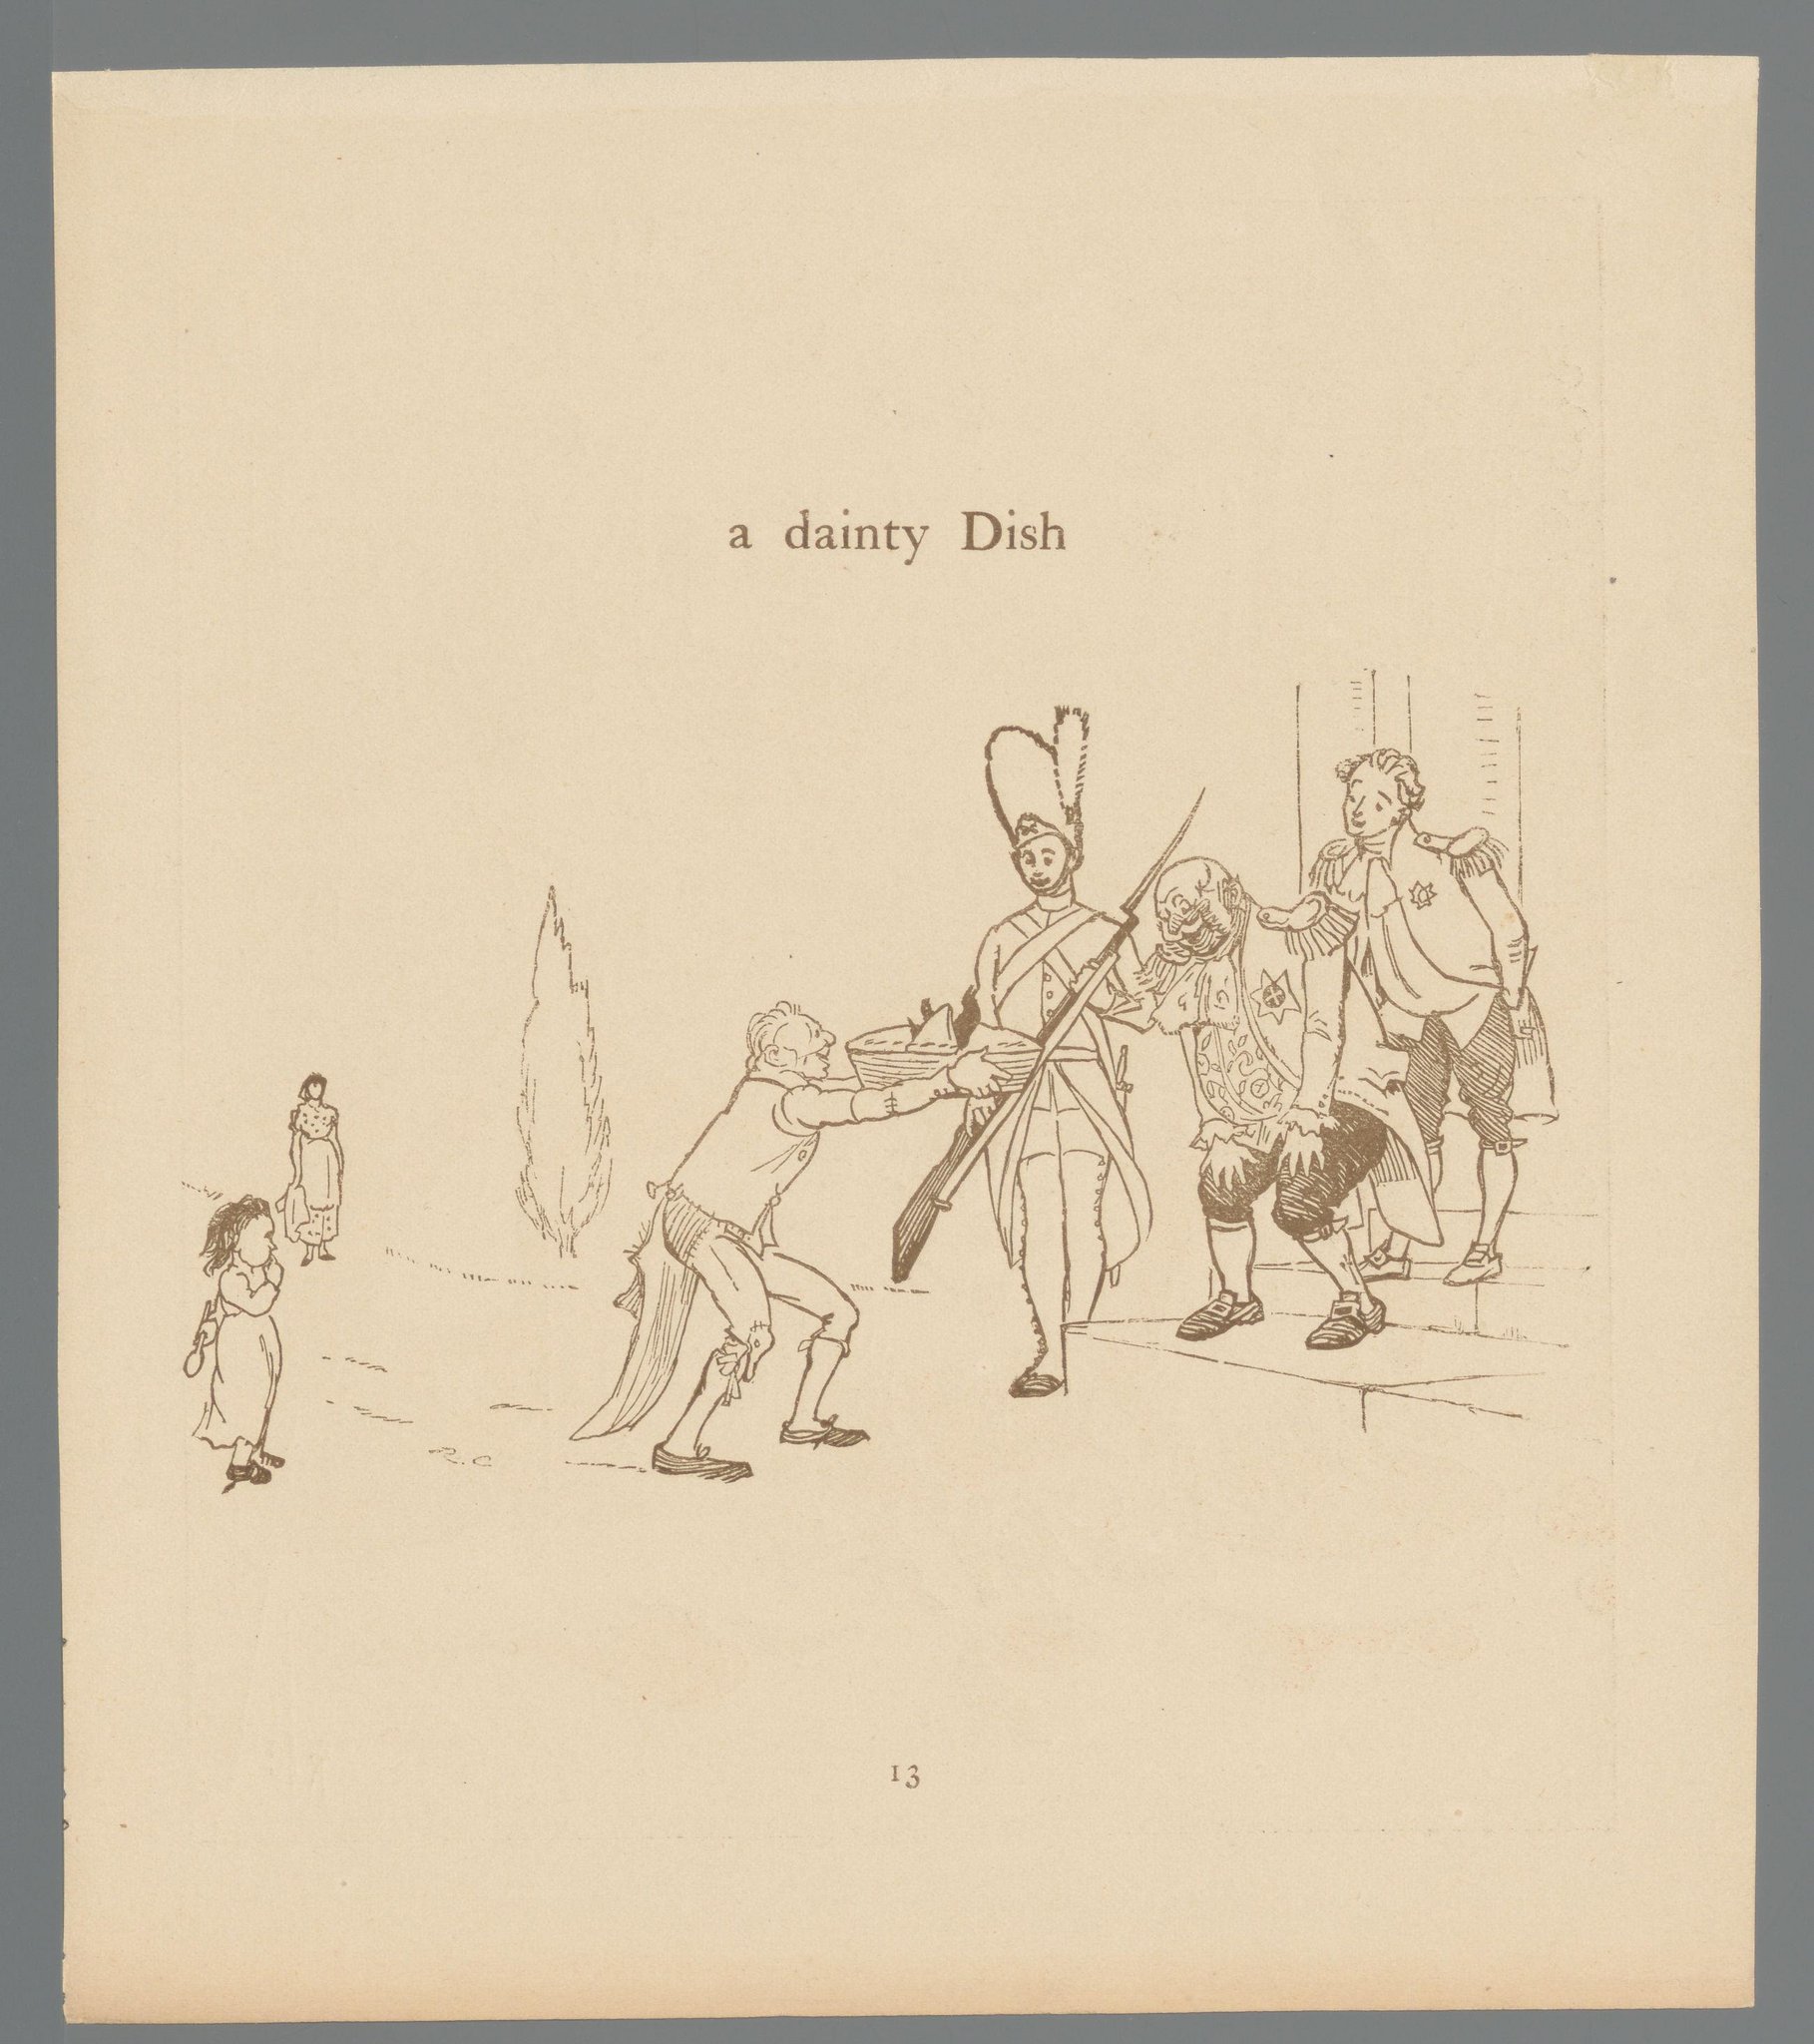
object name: book illustration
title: Man laat taart met vogel zien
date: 1880-1927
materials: paper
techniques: letterpress printing, engraving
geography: london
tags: pie, birds, adult man (+ four persons)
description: Prent uit: Sing a song of sixpence. Londen: George Routledge & Sons, 1880. Of uit een later gepubliceerde (gebundelde) uitgave.